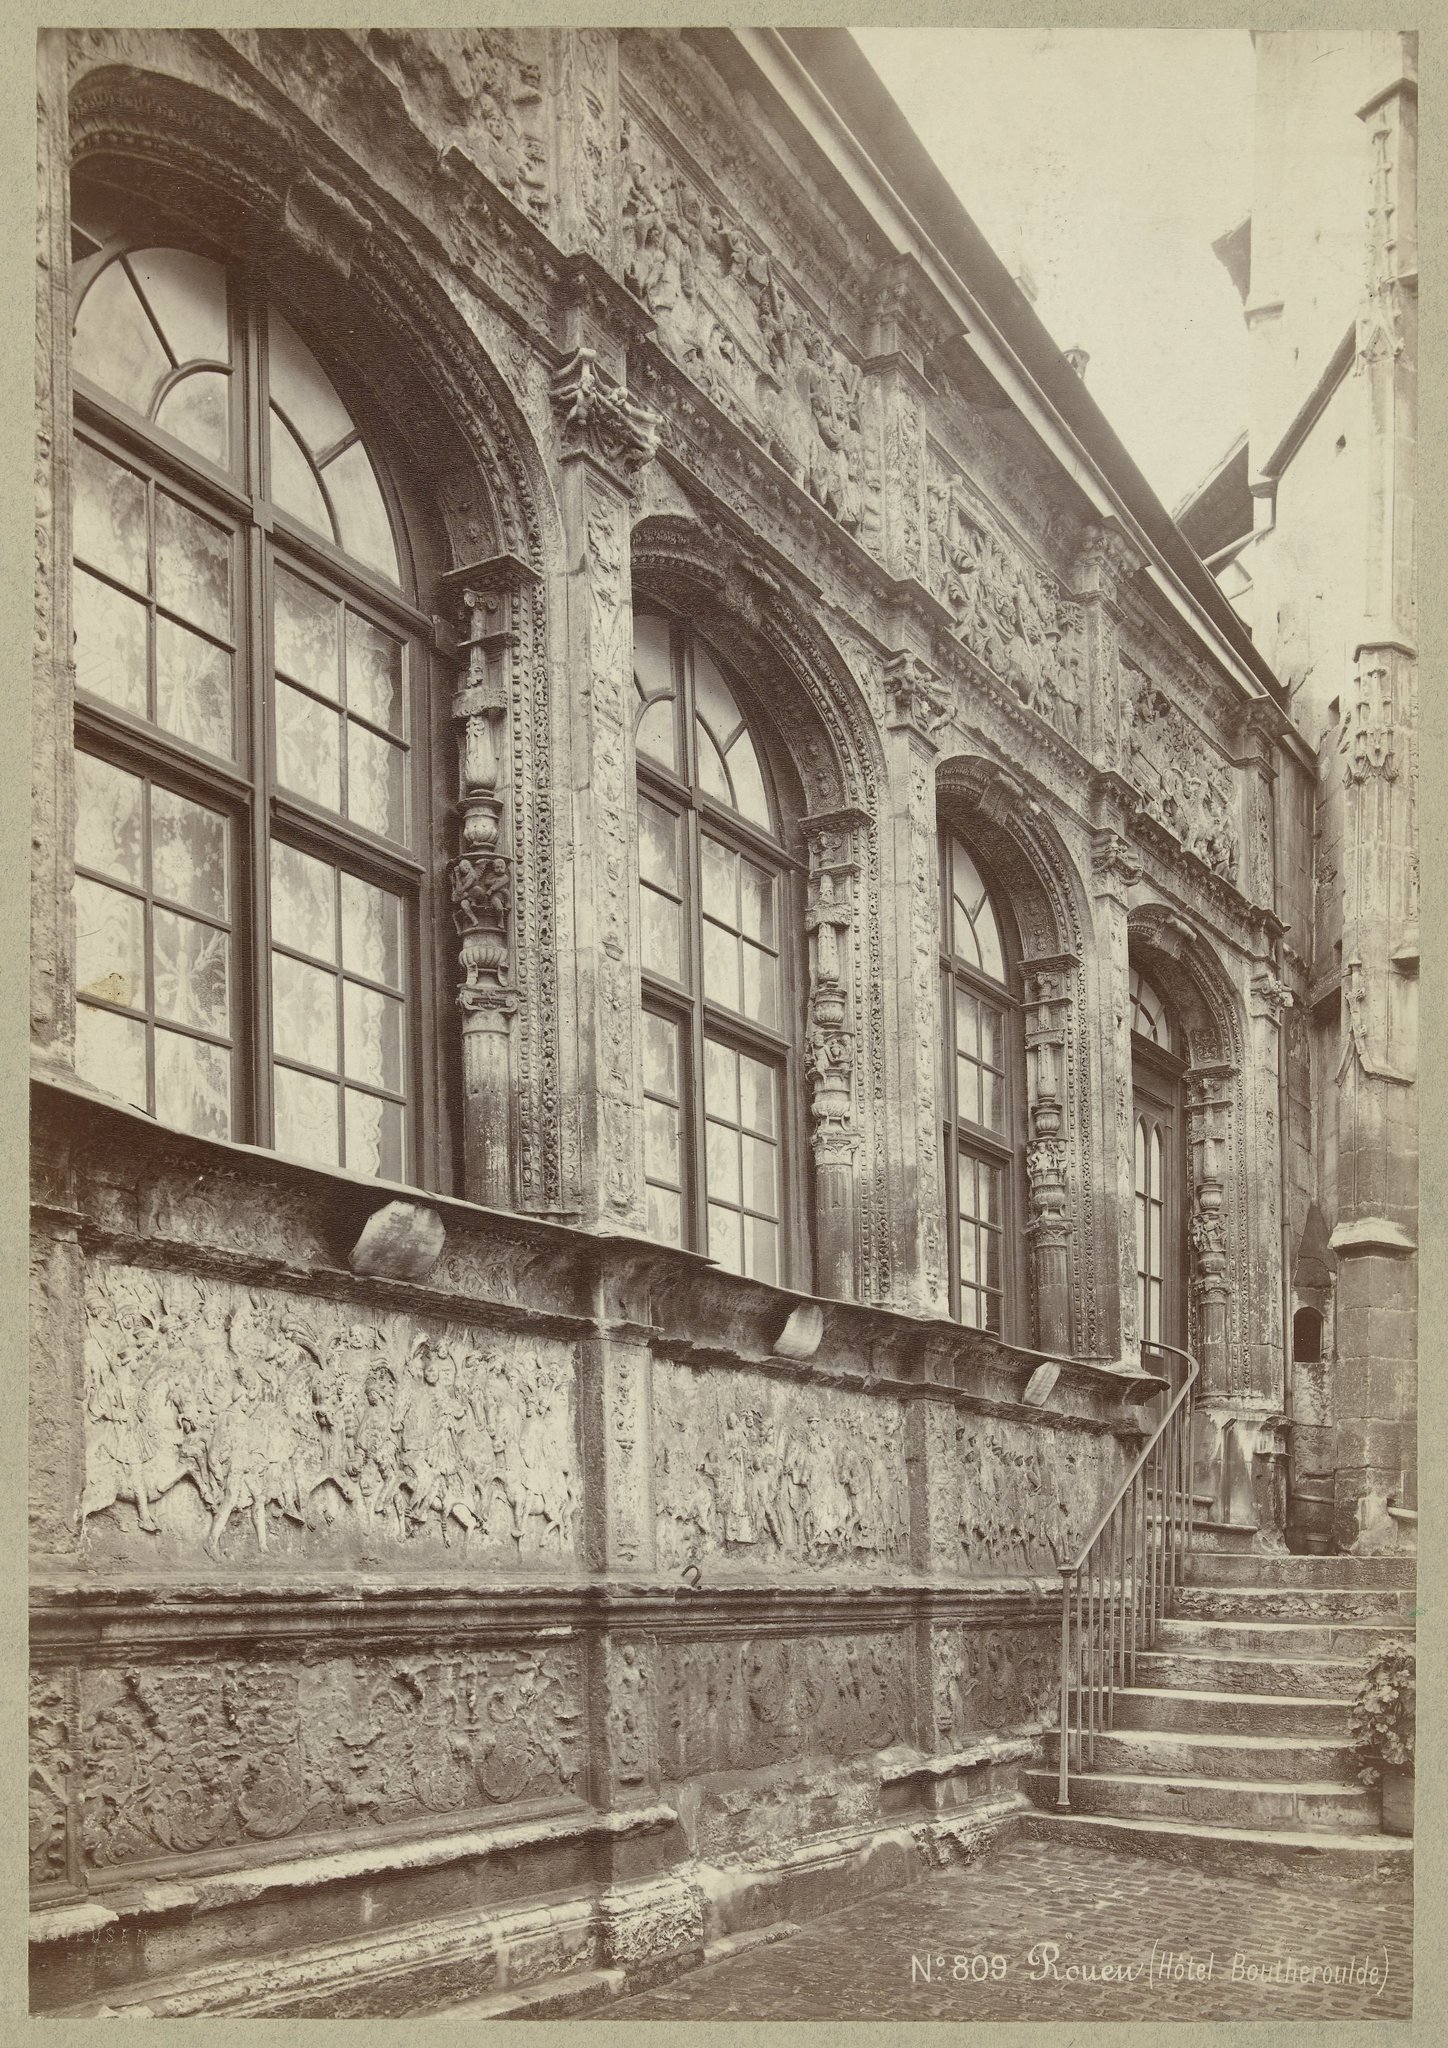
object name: photograph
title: Rouen (Hôtel Boutheroulde)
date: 1870-1894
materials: cardboard, paper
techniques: albumen print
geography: the hague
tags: hôtel, i.e. small palace in city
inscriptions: collector's mark: Lugt 3937, stamp: ‘kunstboekhandel/ J.A.G. de Leur/ photograaf - uitgever/ Huigenspark, 40b./ Den Haag’, inscription: ‘No. 809 Rouen (Hôtel Boutheroulde)’, check stamp: ‘Mieusement/ Photographe’